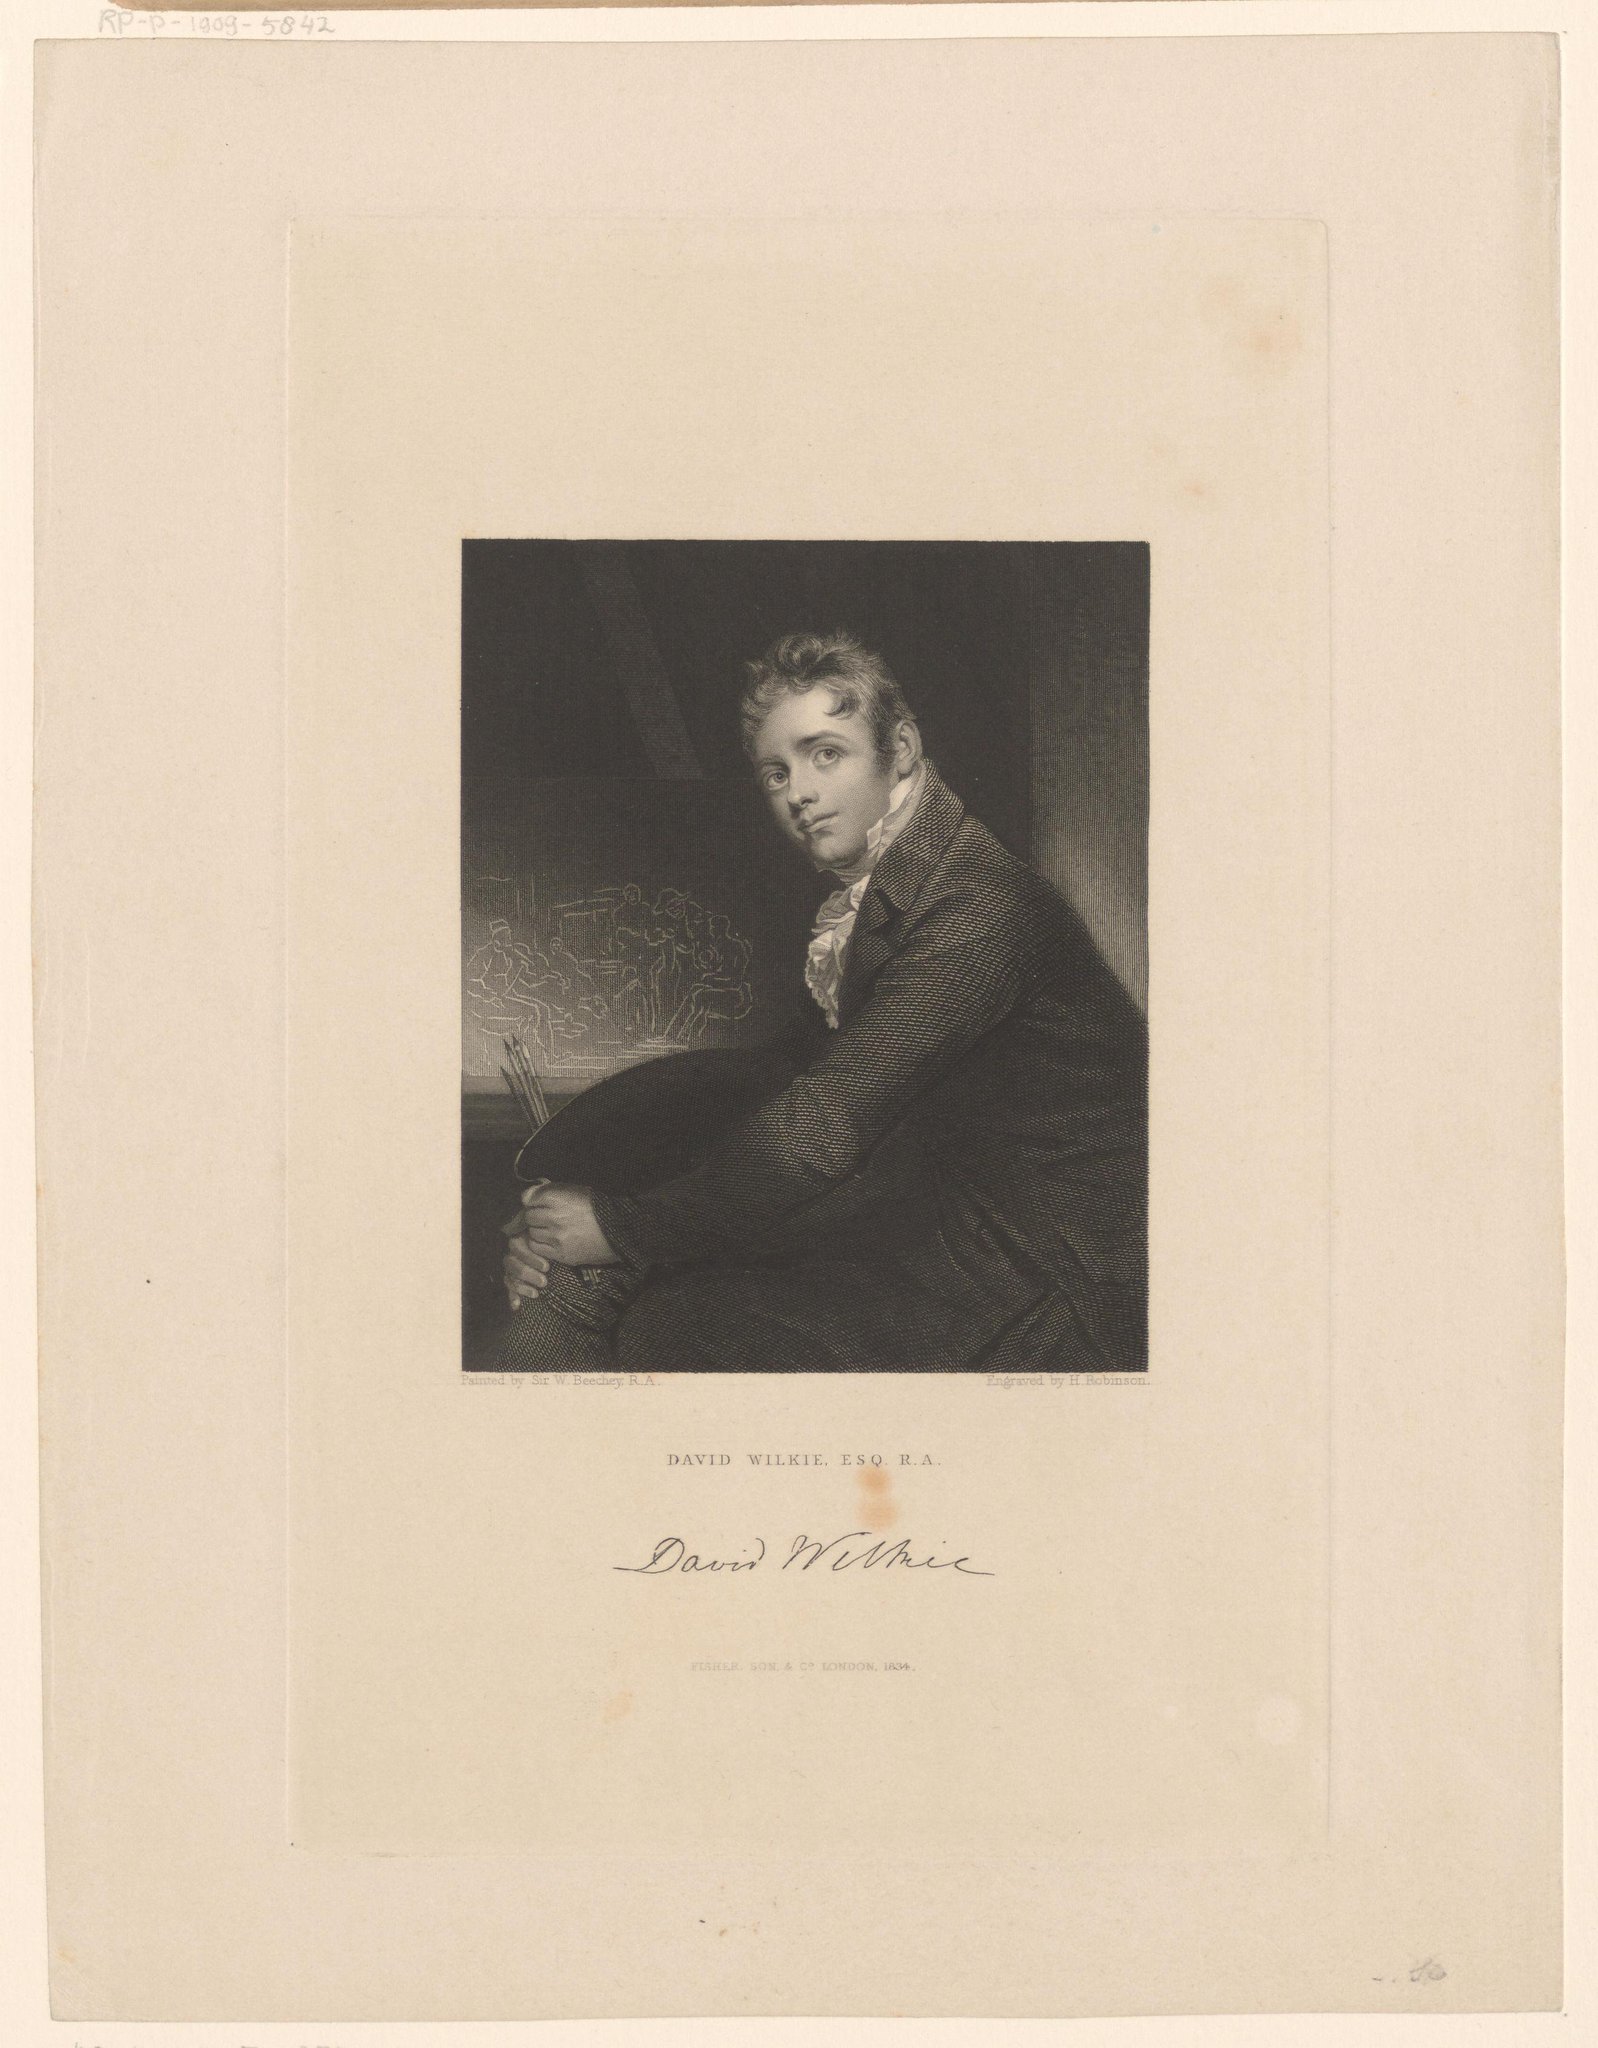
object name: book illustration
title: Portret van David Wilkie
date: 1834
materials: paper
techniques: engraving, etching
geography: london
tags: draughtsman, david wilkie, historical persons, portrait, self-portrait of graphic artist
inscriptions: collector's mark: Lugt 2228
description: Prent gebruikt in: Jerdan, William. National Portrait Gallery of Illustrious and Eminent Personages of the Nineteenth Century. Londen: Fisher, Son, & Co, 1834.